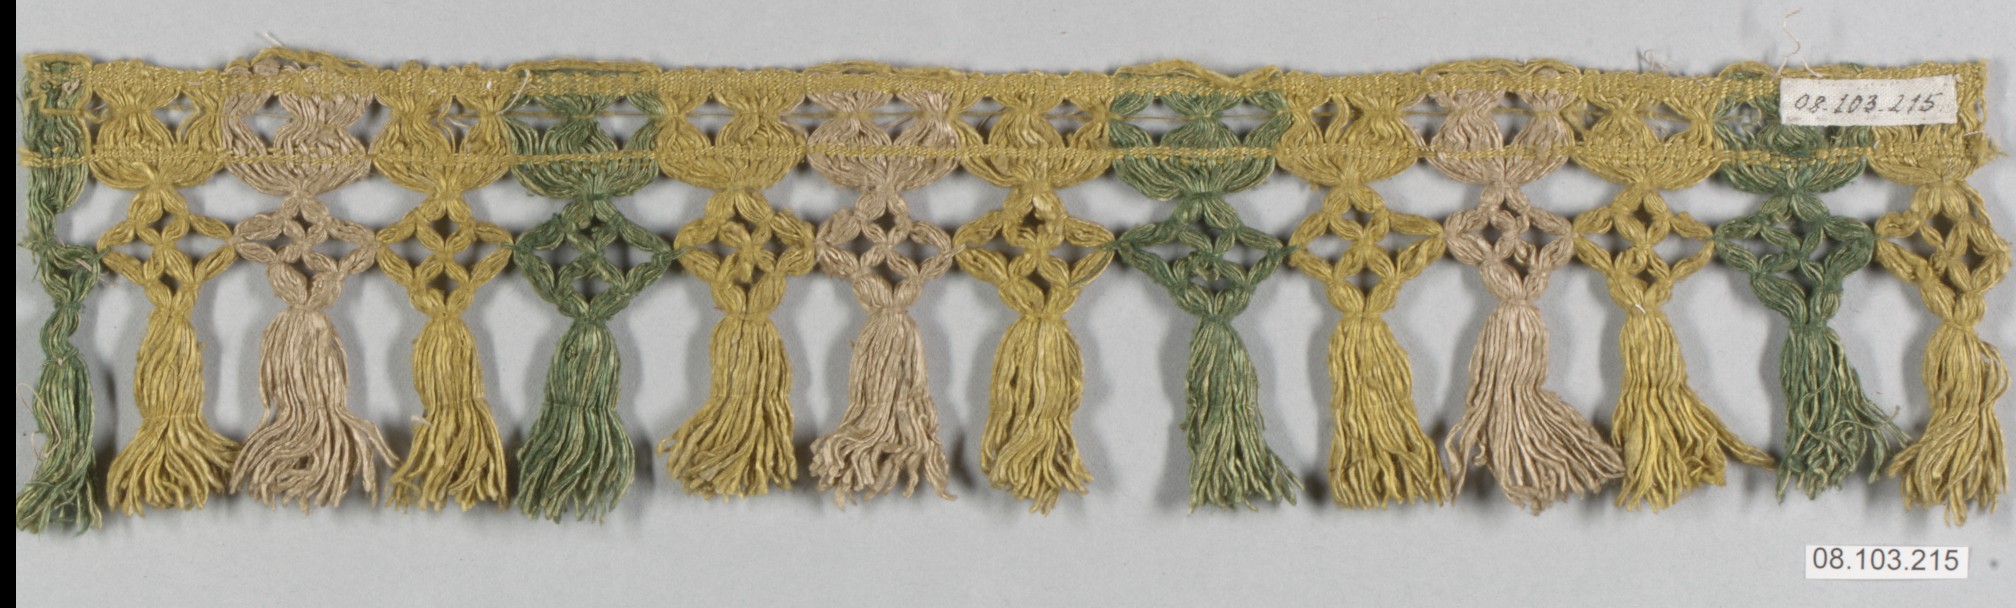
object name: fringe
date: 1701-1800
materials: cotton